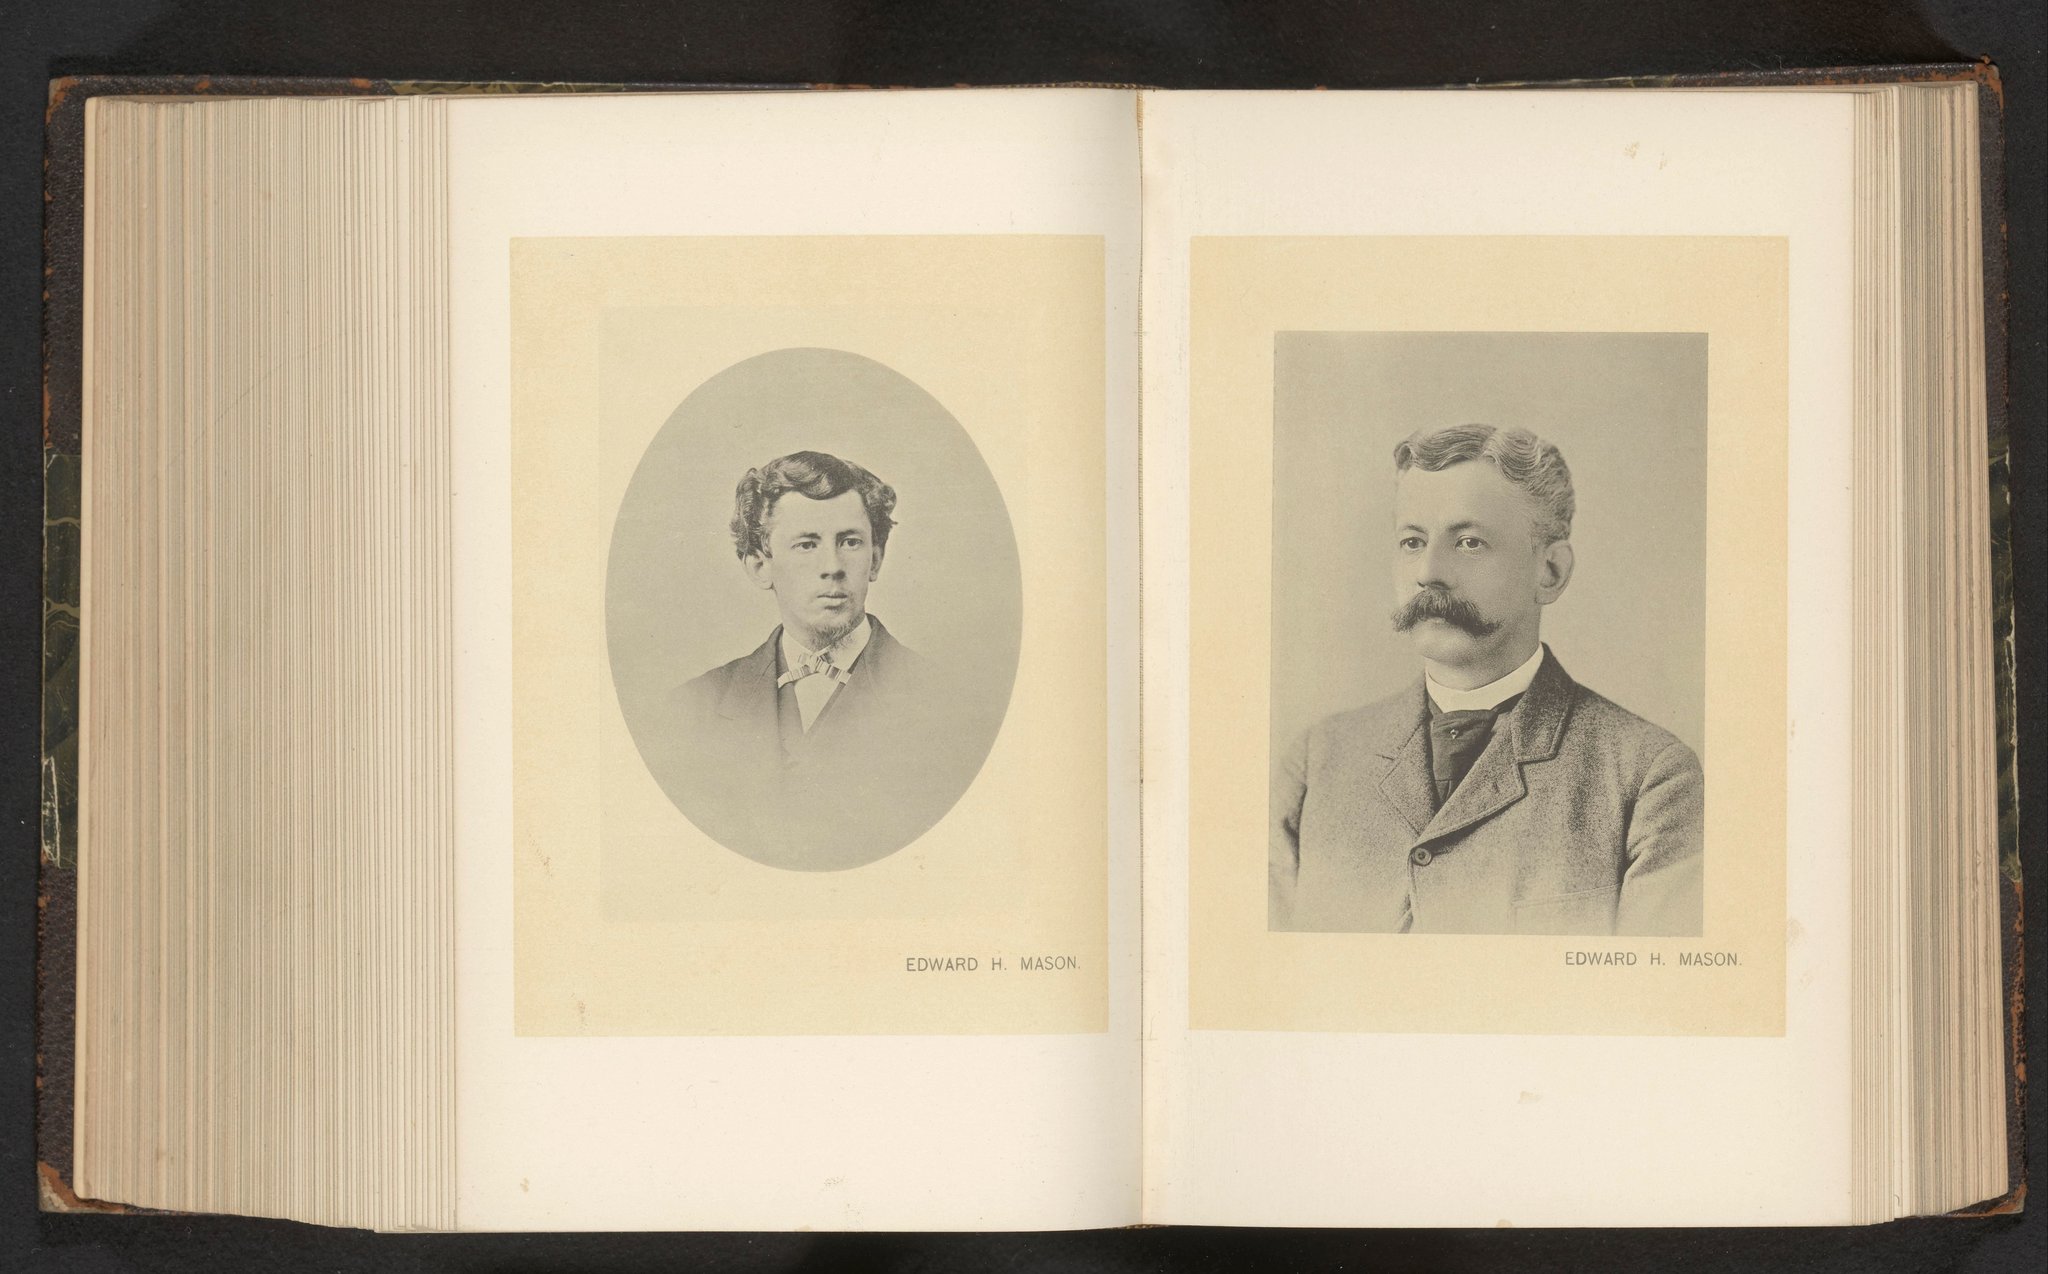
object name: photomechanical print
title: Edward H. Mason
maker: Anonymous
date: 1869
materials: paper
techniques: photoaquatint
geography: boston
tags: adult man